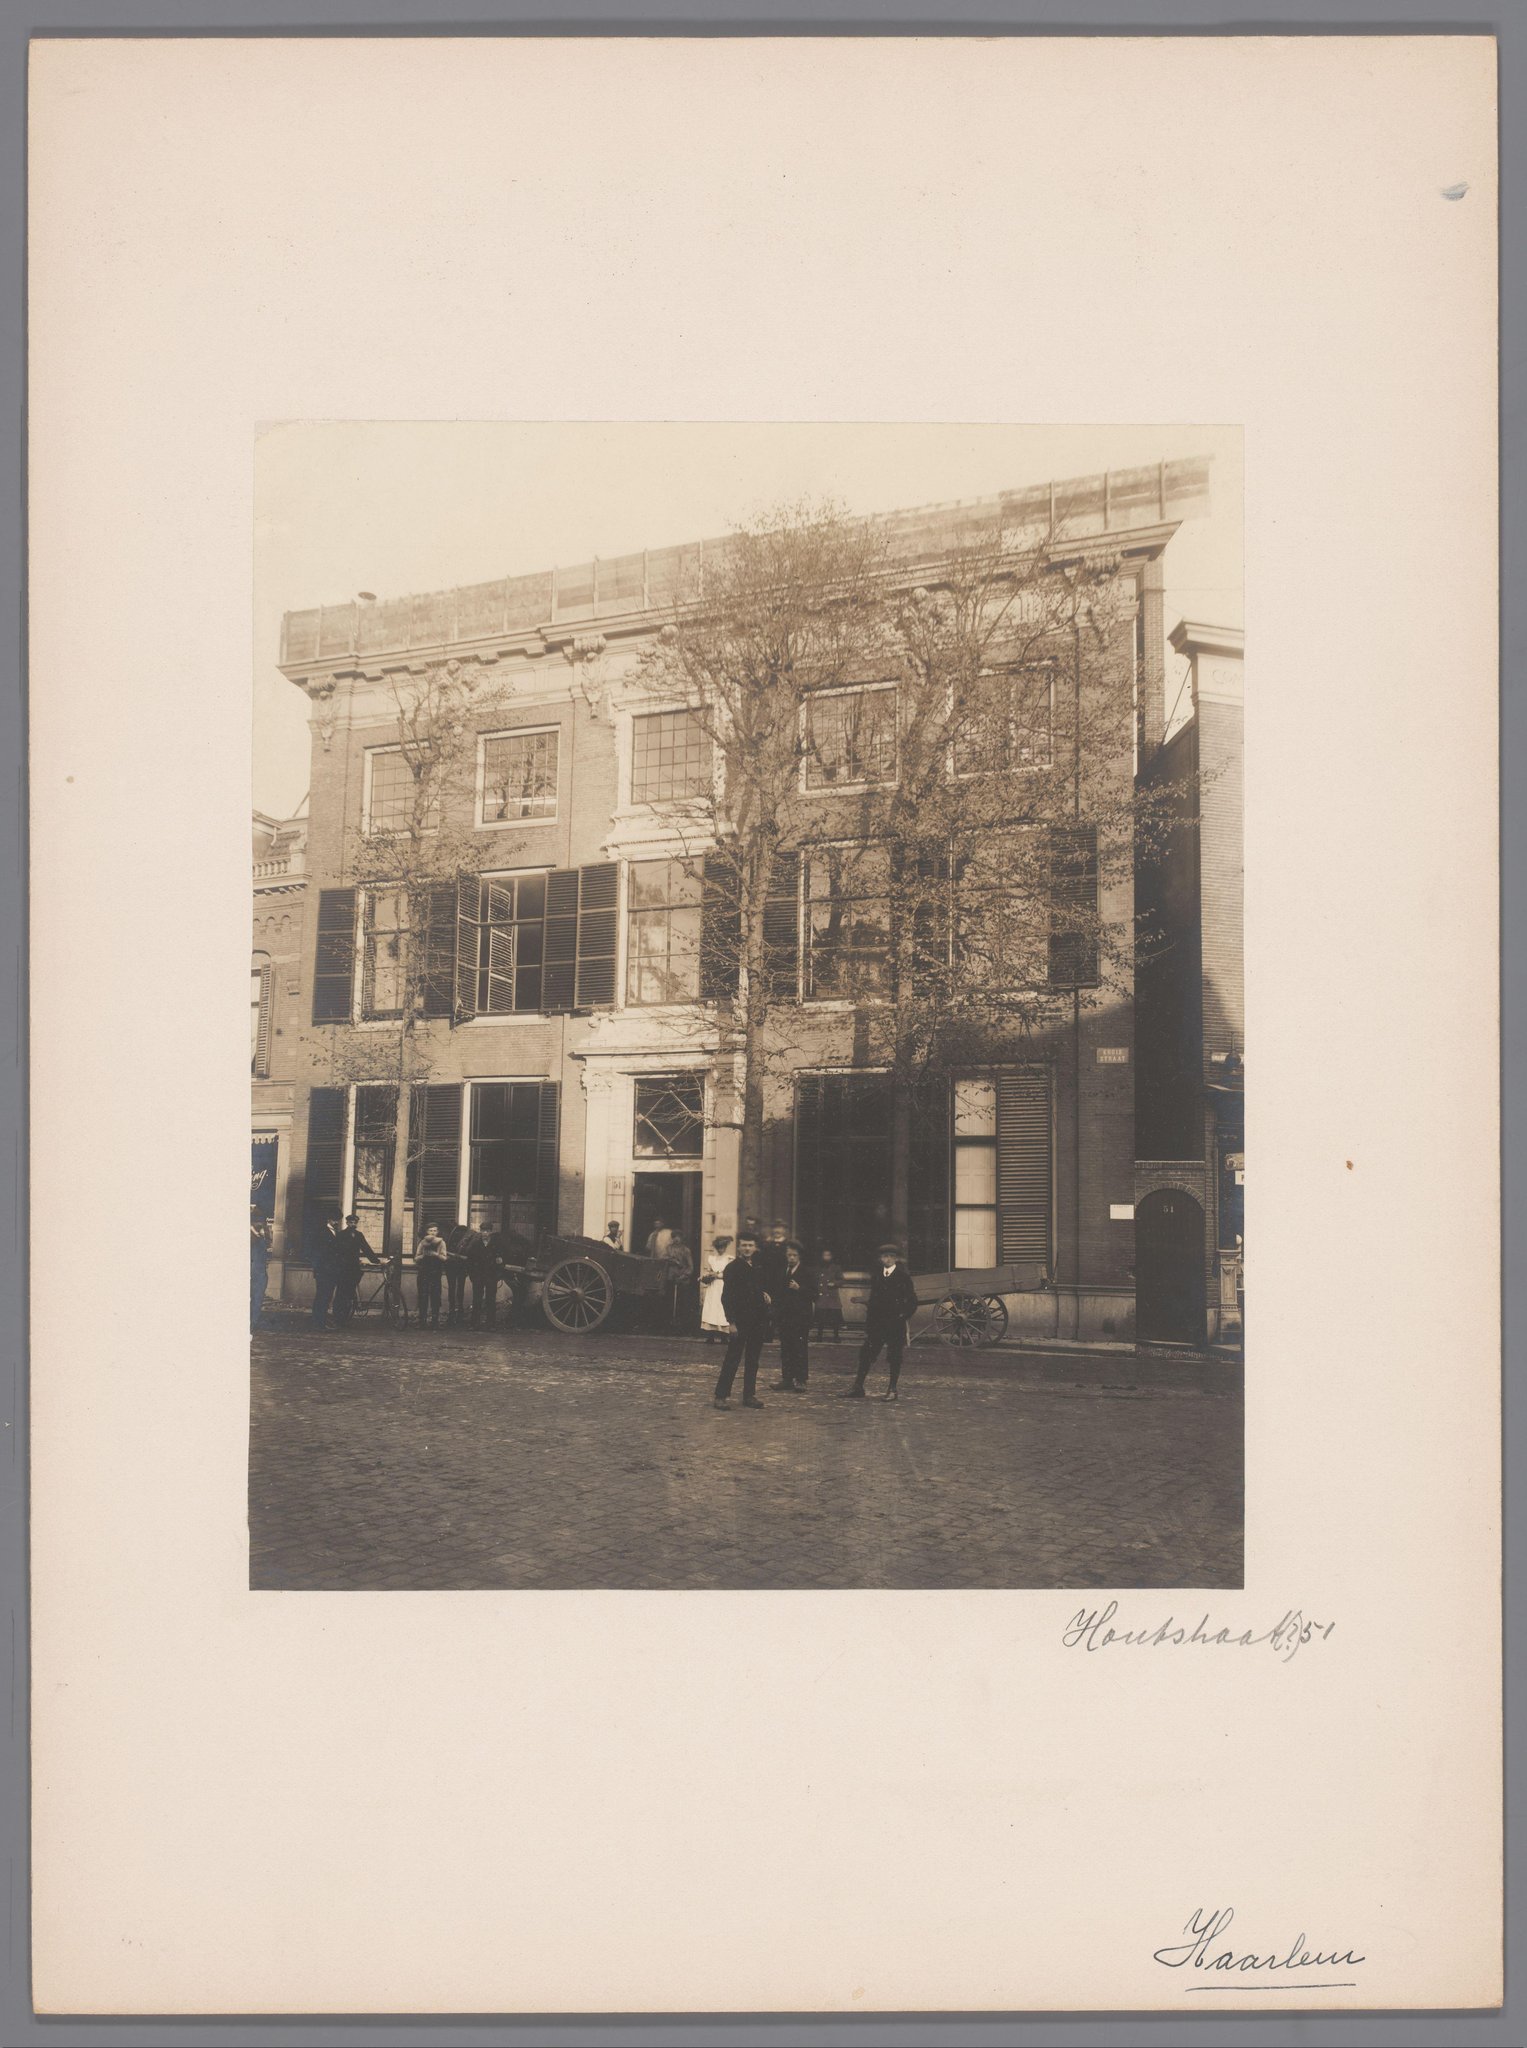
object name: photograph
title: Gezicht op Kruisstraat 51 te Haarlem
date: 1906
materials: cardboard, photographic support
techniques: gelatin silver print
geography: kruisstraat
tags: façade (of house or building), civic architecture; edifices; dwellings, street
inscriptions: annotation: ‘Haarlem. Houtstraat 51 (N.H.)/ Oct: 1906’, annotation: ‘Houtstraat (?) 51/ Haarlem’